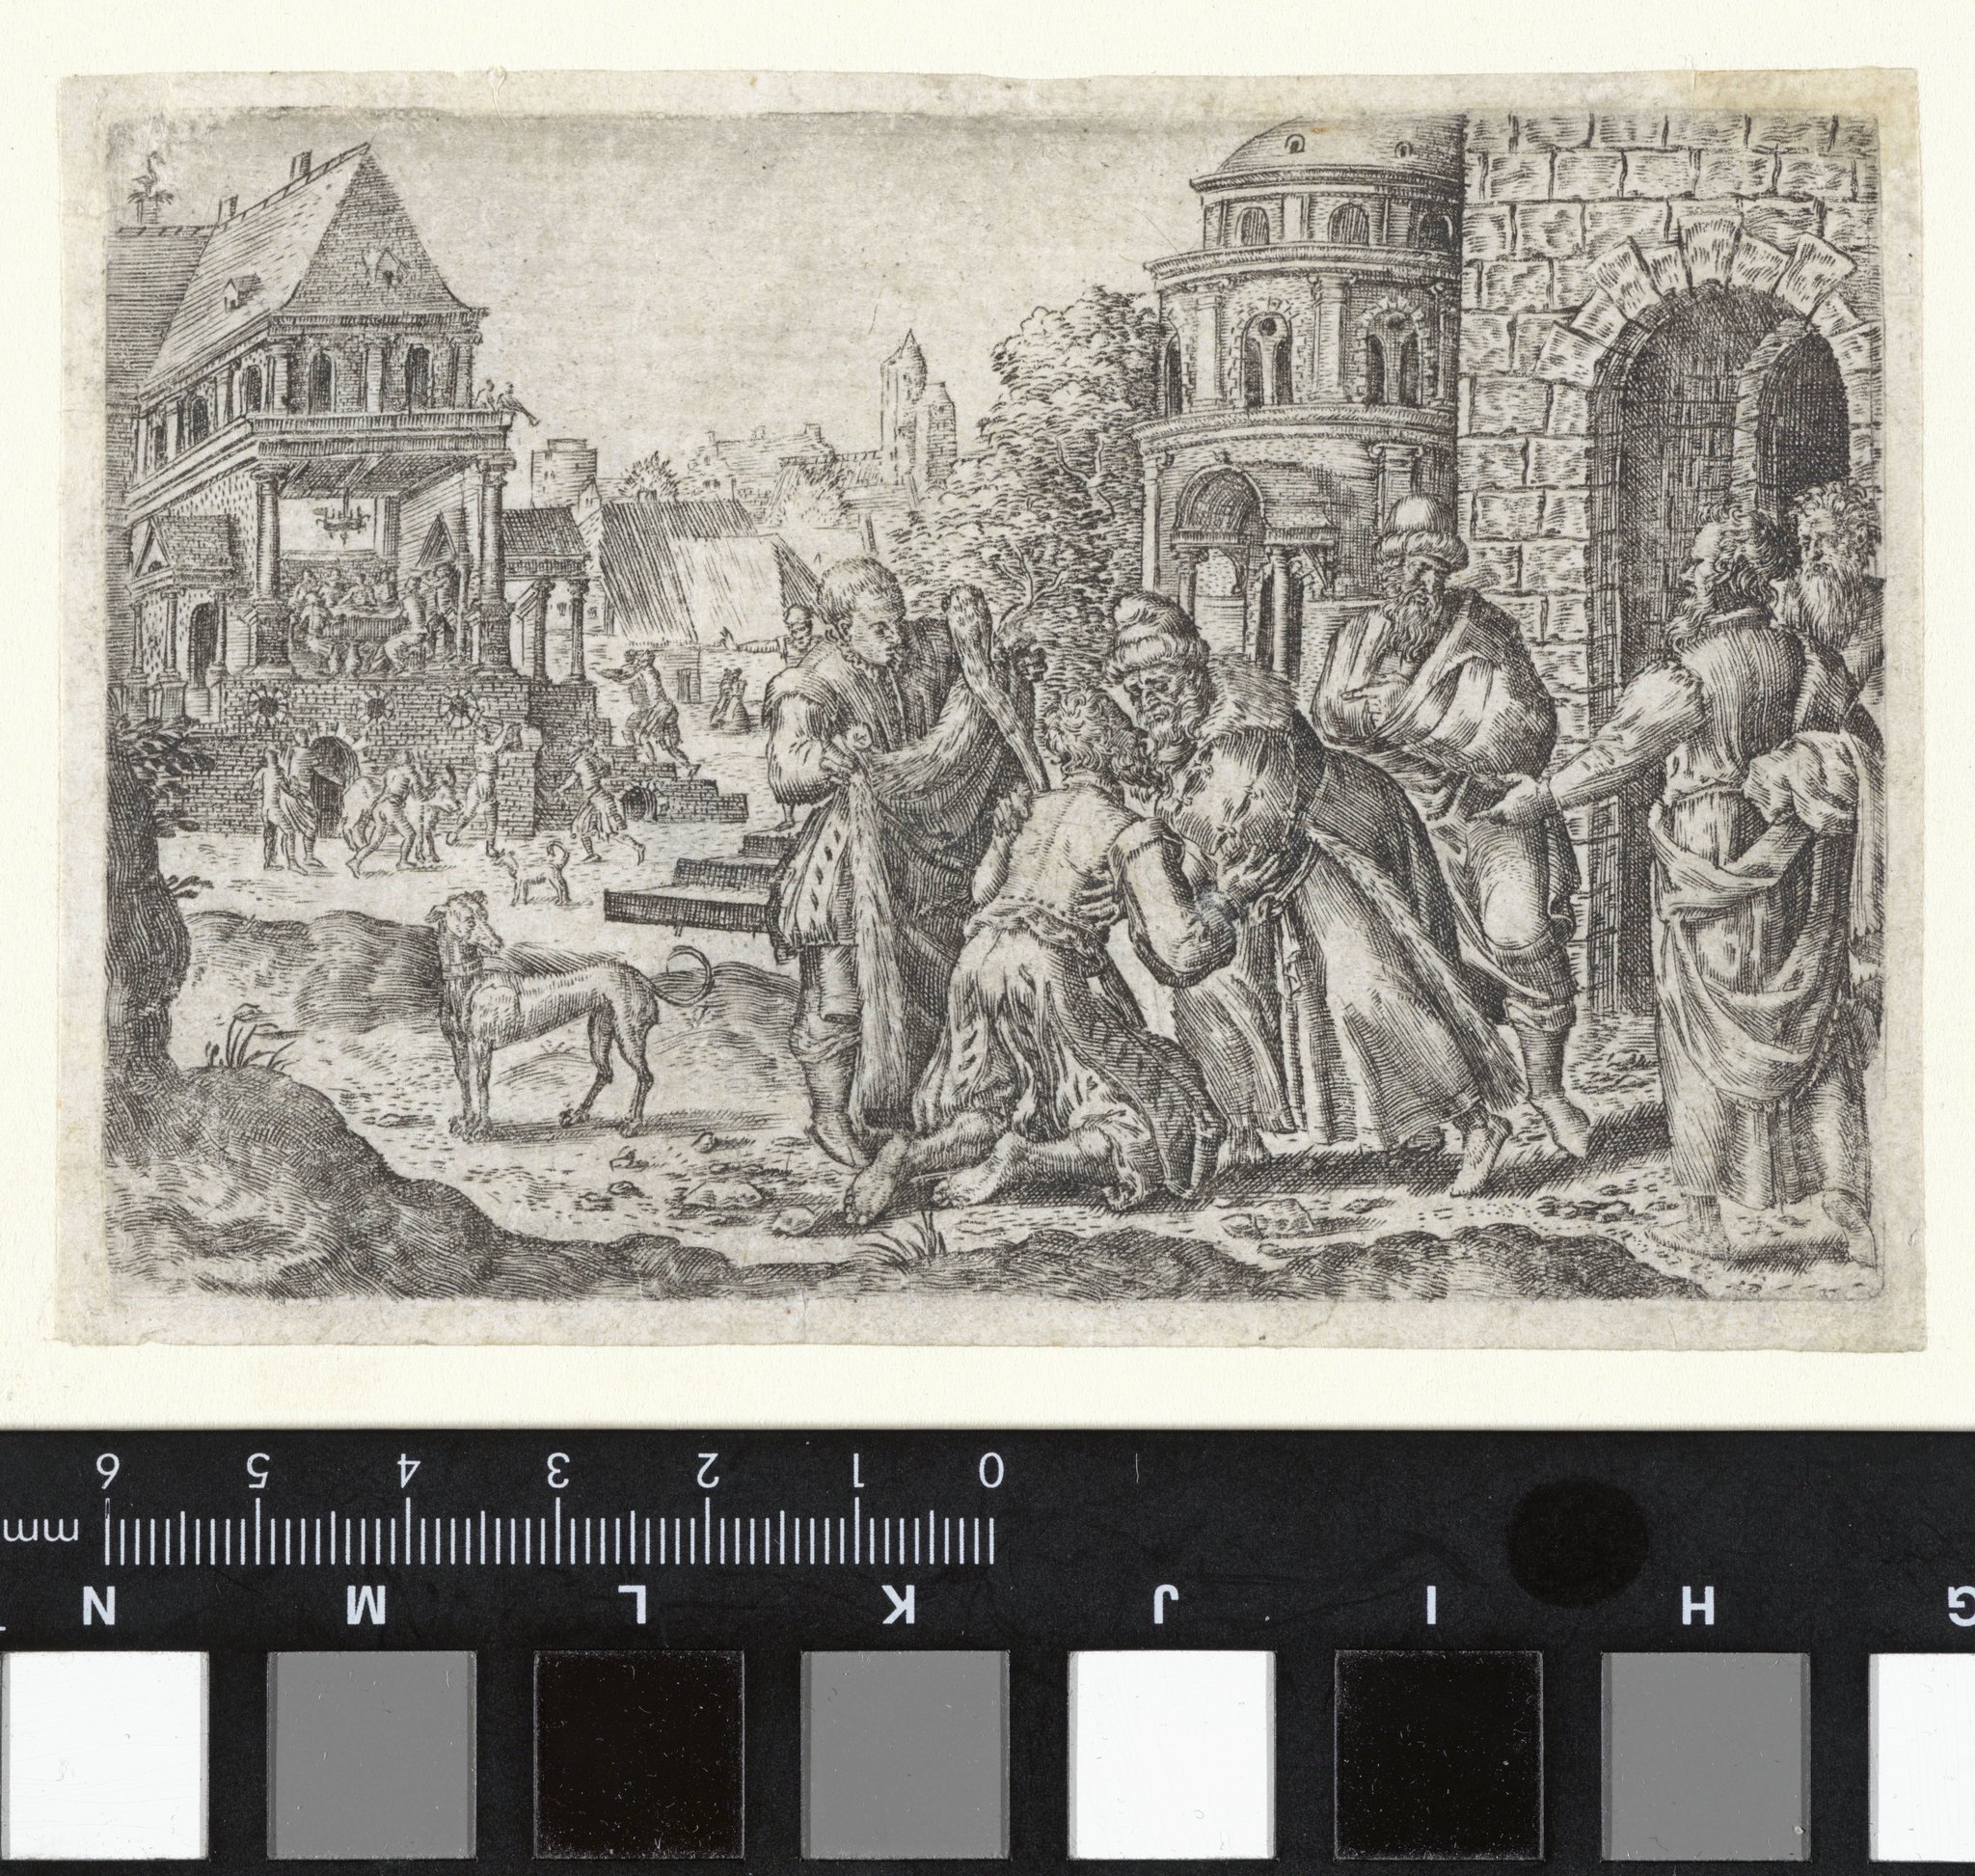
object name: print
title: Terugkeer van de verloren zoon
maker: Anonymous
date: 1550-1643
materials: paper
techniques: etching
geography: low countries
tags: the prodigal son kneels before his father who takes him in his arms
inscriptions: collector's mark: Lugt 2760, collector's mark: Lugt 2228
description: De verloren zoon knielt voor zijn vader, die hem omhelst. Een man staat op het punt om een mantel om de zoon heen te slaan. Enkele figuren kijken toe. Achter hen een dorp.